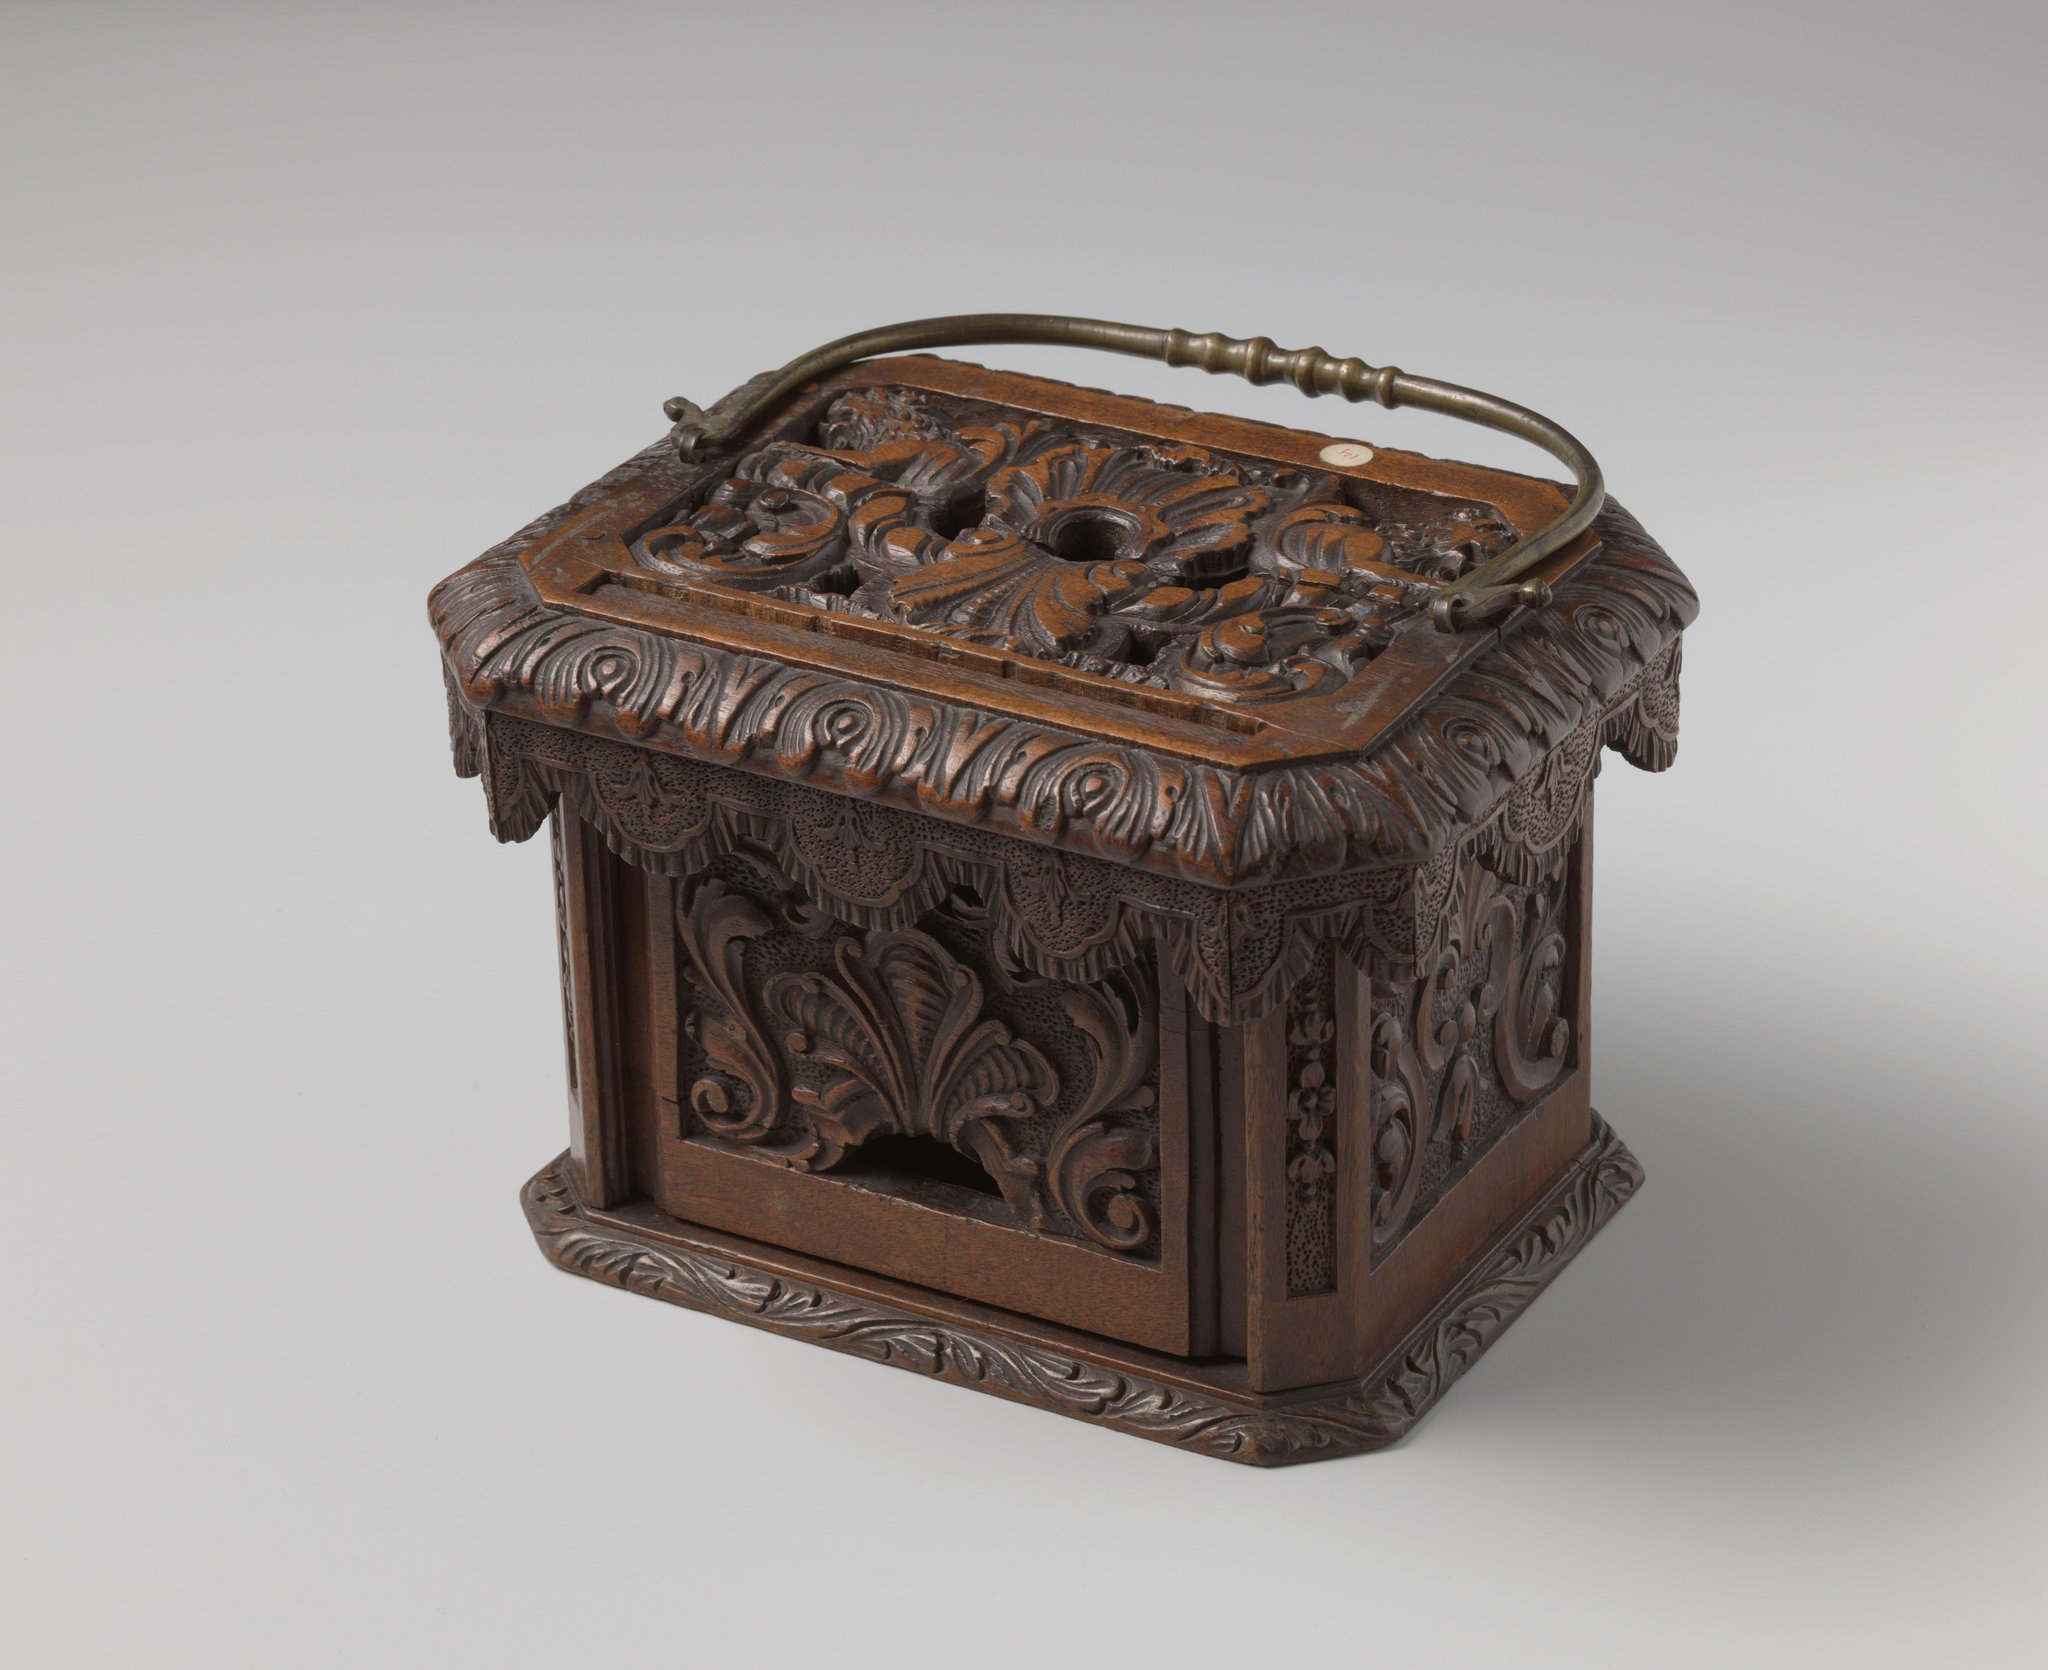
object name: furniture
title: Stoof, rijk gesneden en met hengsel van koper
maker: Anonymous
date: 1700-1715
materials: copper, wood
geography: northern netherlands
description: Stoof met afgeschuinde hoeken, van palissanderhout. De stoof is rijk gesneden en heeft een koperen hengsel.